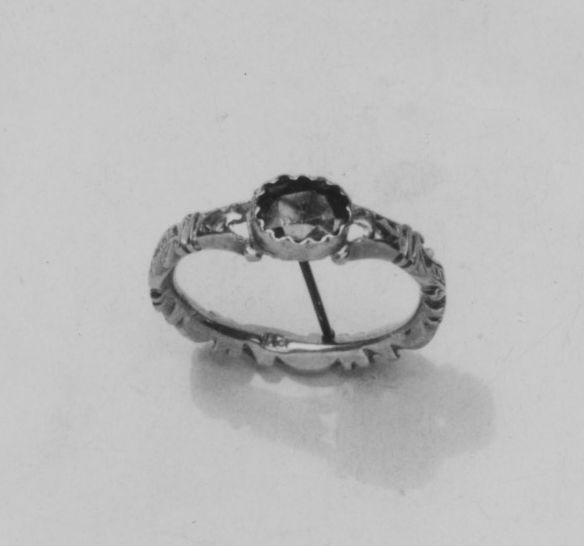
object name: ring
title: Mourning Ring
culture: american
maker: elmkin hitchcock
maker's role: maker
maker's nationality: american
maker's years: 1726-1788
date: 1758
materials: gemstone, gold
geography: united states